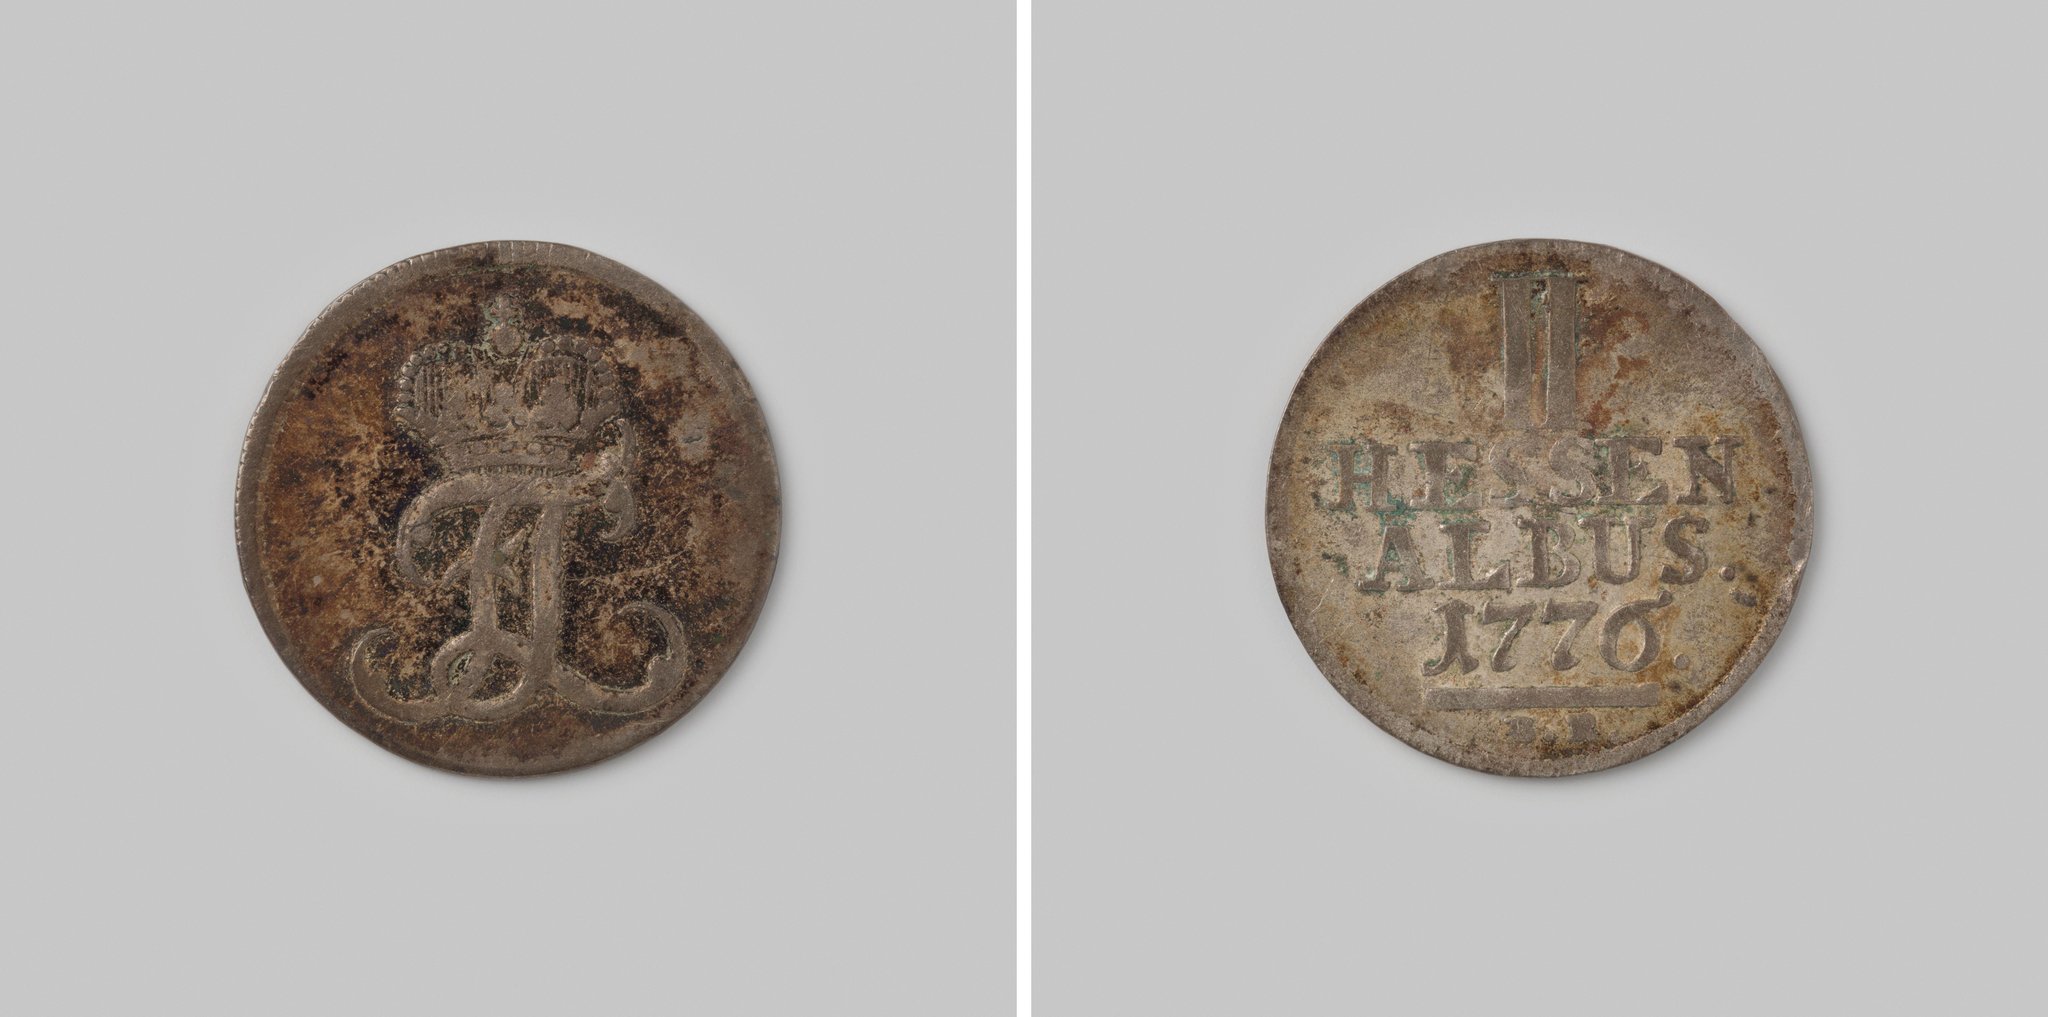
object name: coin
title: 2 Albus van Hessen uit Hessen-Kassel van Friedrich II, 1776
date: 1776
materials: silver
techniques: striking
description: Koper-zilveren munt. Voorzijde: gekroond monogram. Keerzijde: waarde-aanduiding in drie regels, waaronder jaartal. Gladde rand.